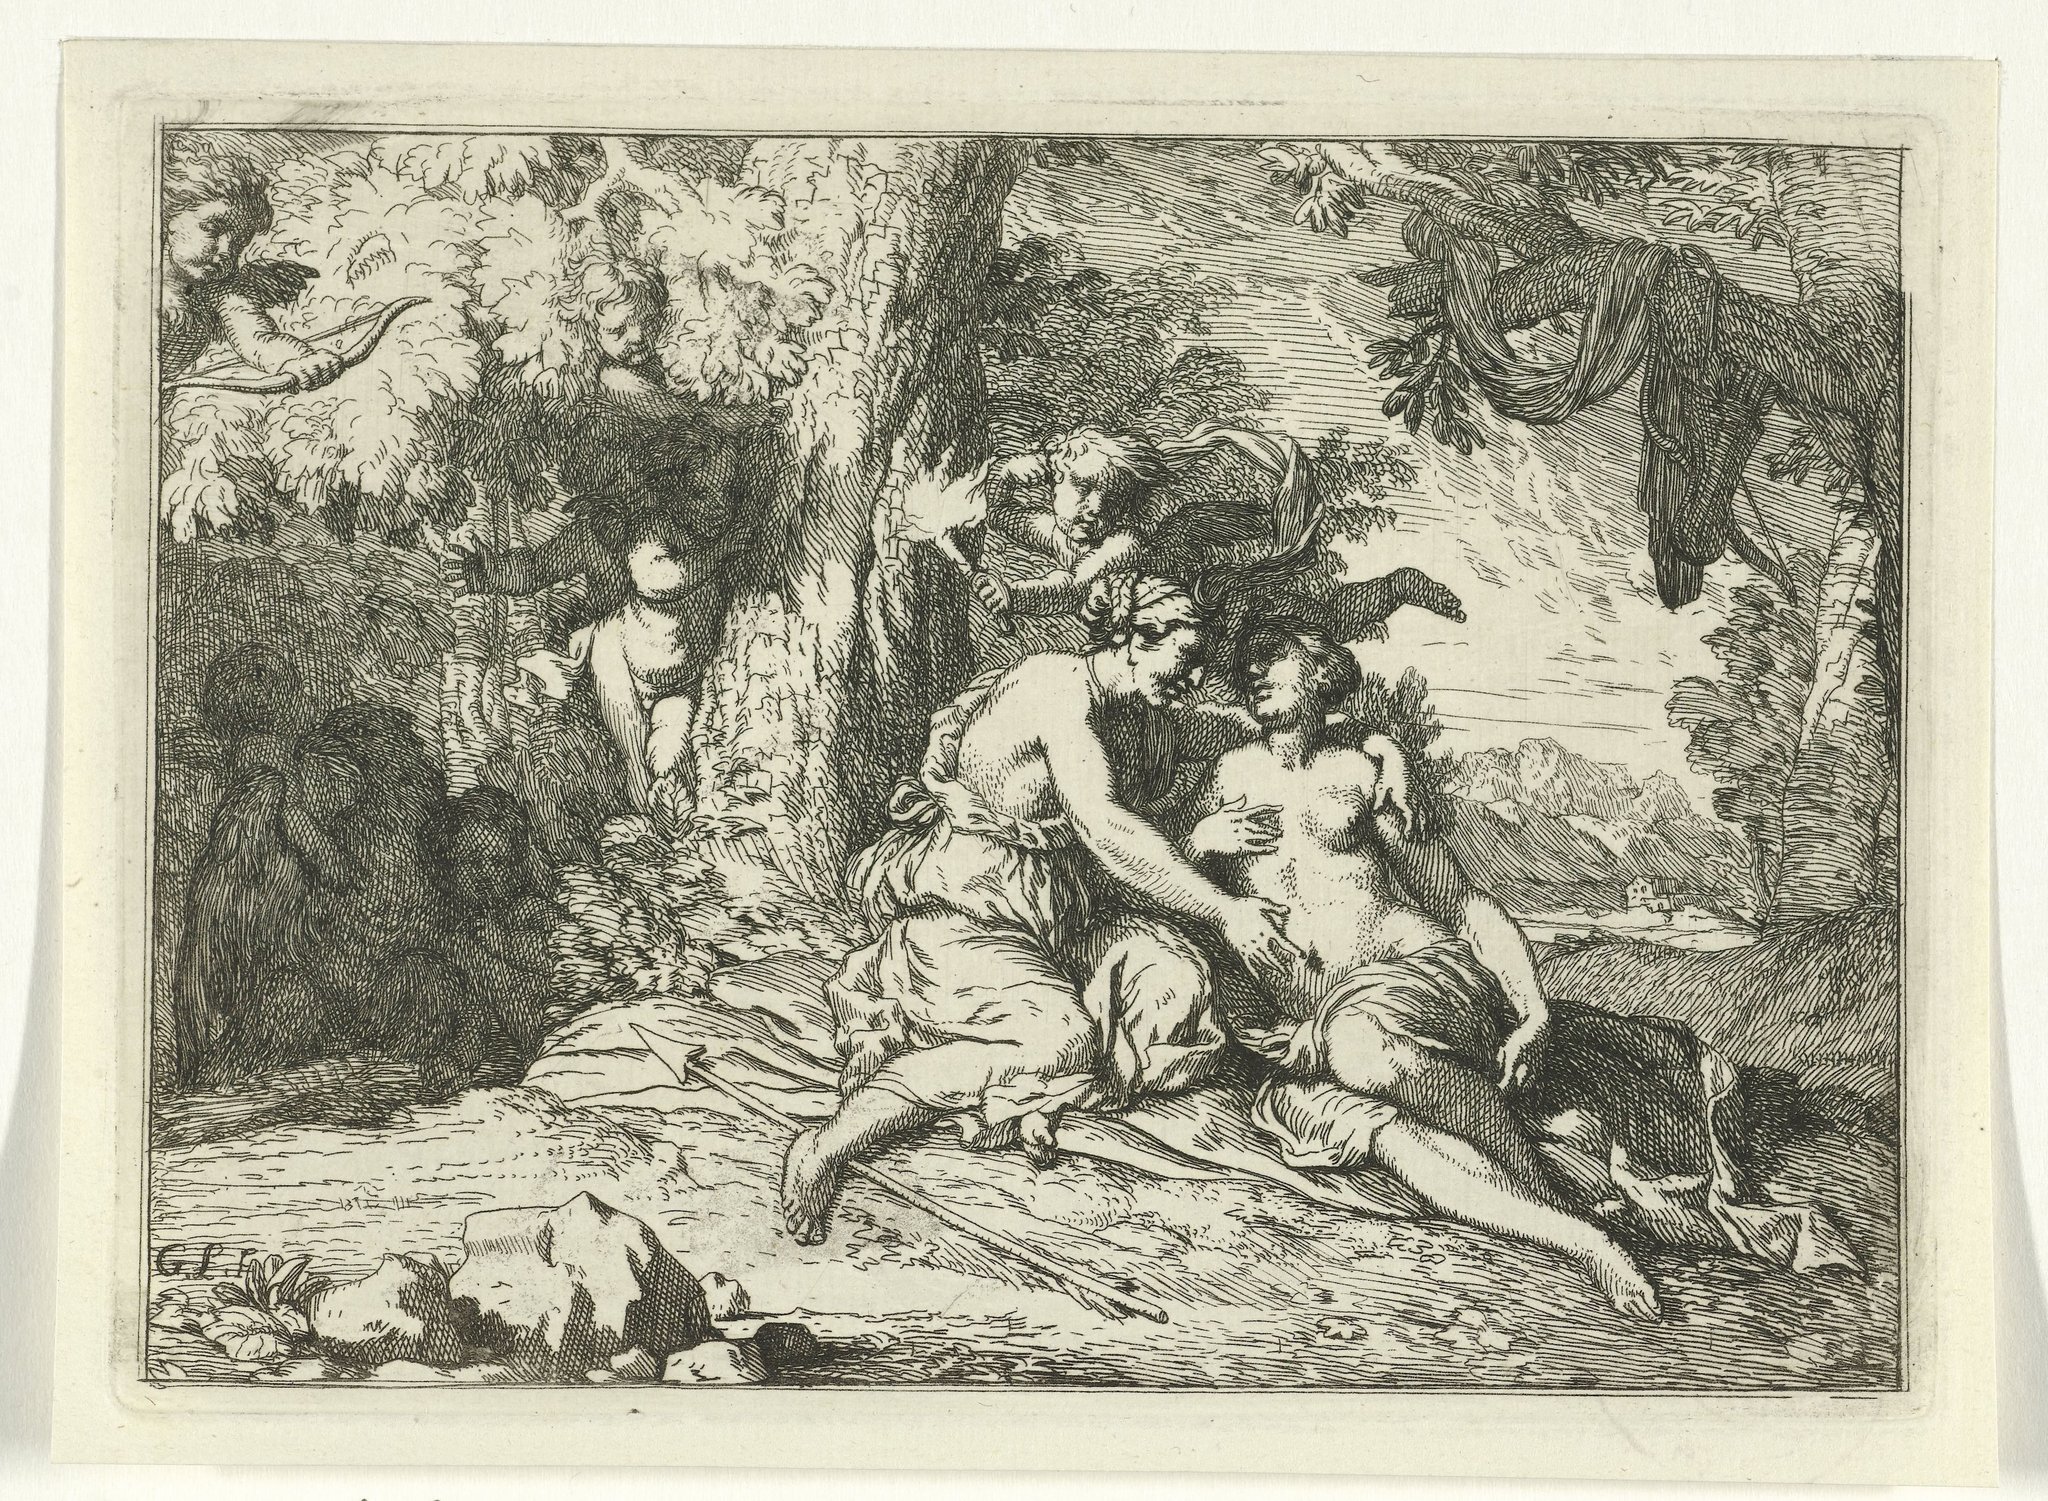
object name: print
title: Jupiter en Callisto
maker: gerard de lairesse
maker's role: draughtsman, painter, print maker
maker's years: 1641-1711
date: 1670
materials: paper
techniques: etching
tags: jupiter, in the guise of diana, and callisto, homosexual love - cc - homosexual love between women: lesbianism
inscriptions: collector's mark: Lugt 240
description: Jupiter benadert de nimf Callisto in de gedaante van de godin Diana. Callisto ligt in de armen van Jupiter onder een boom, het tweetal wordt omringd door nieuwsgierige putti. Scène uit de Metamorfosen van Ovidius.